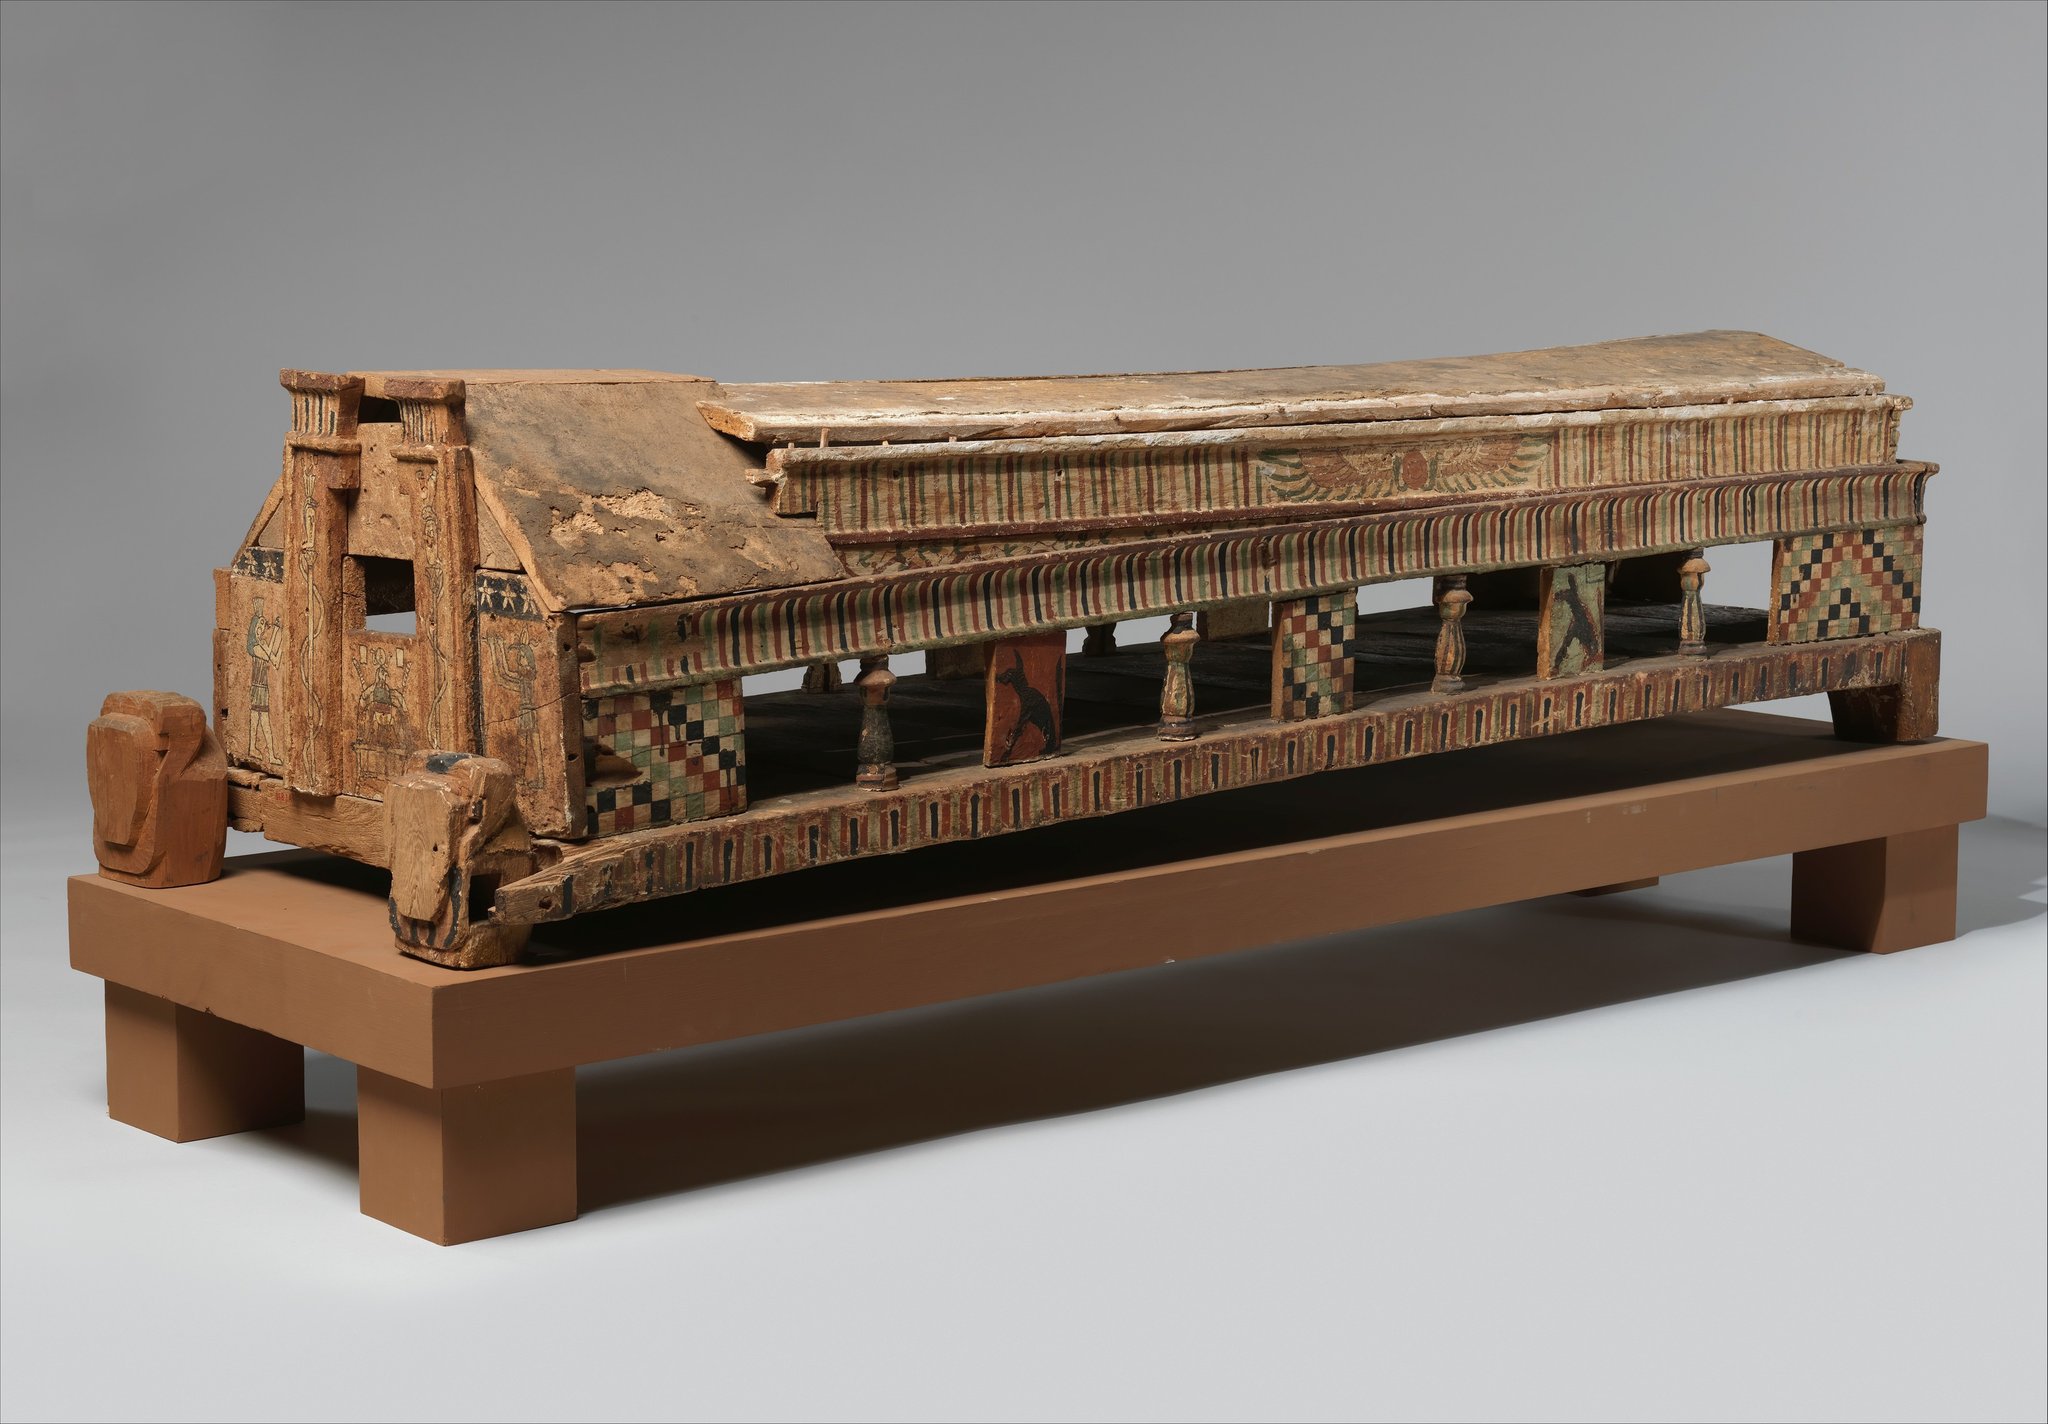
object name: coffin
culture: coptic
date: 301-400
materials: paint, wood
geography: egypt